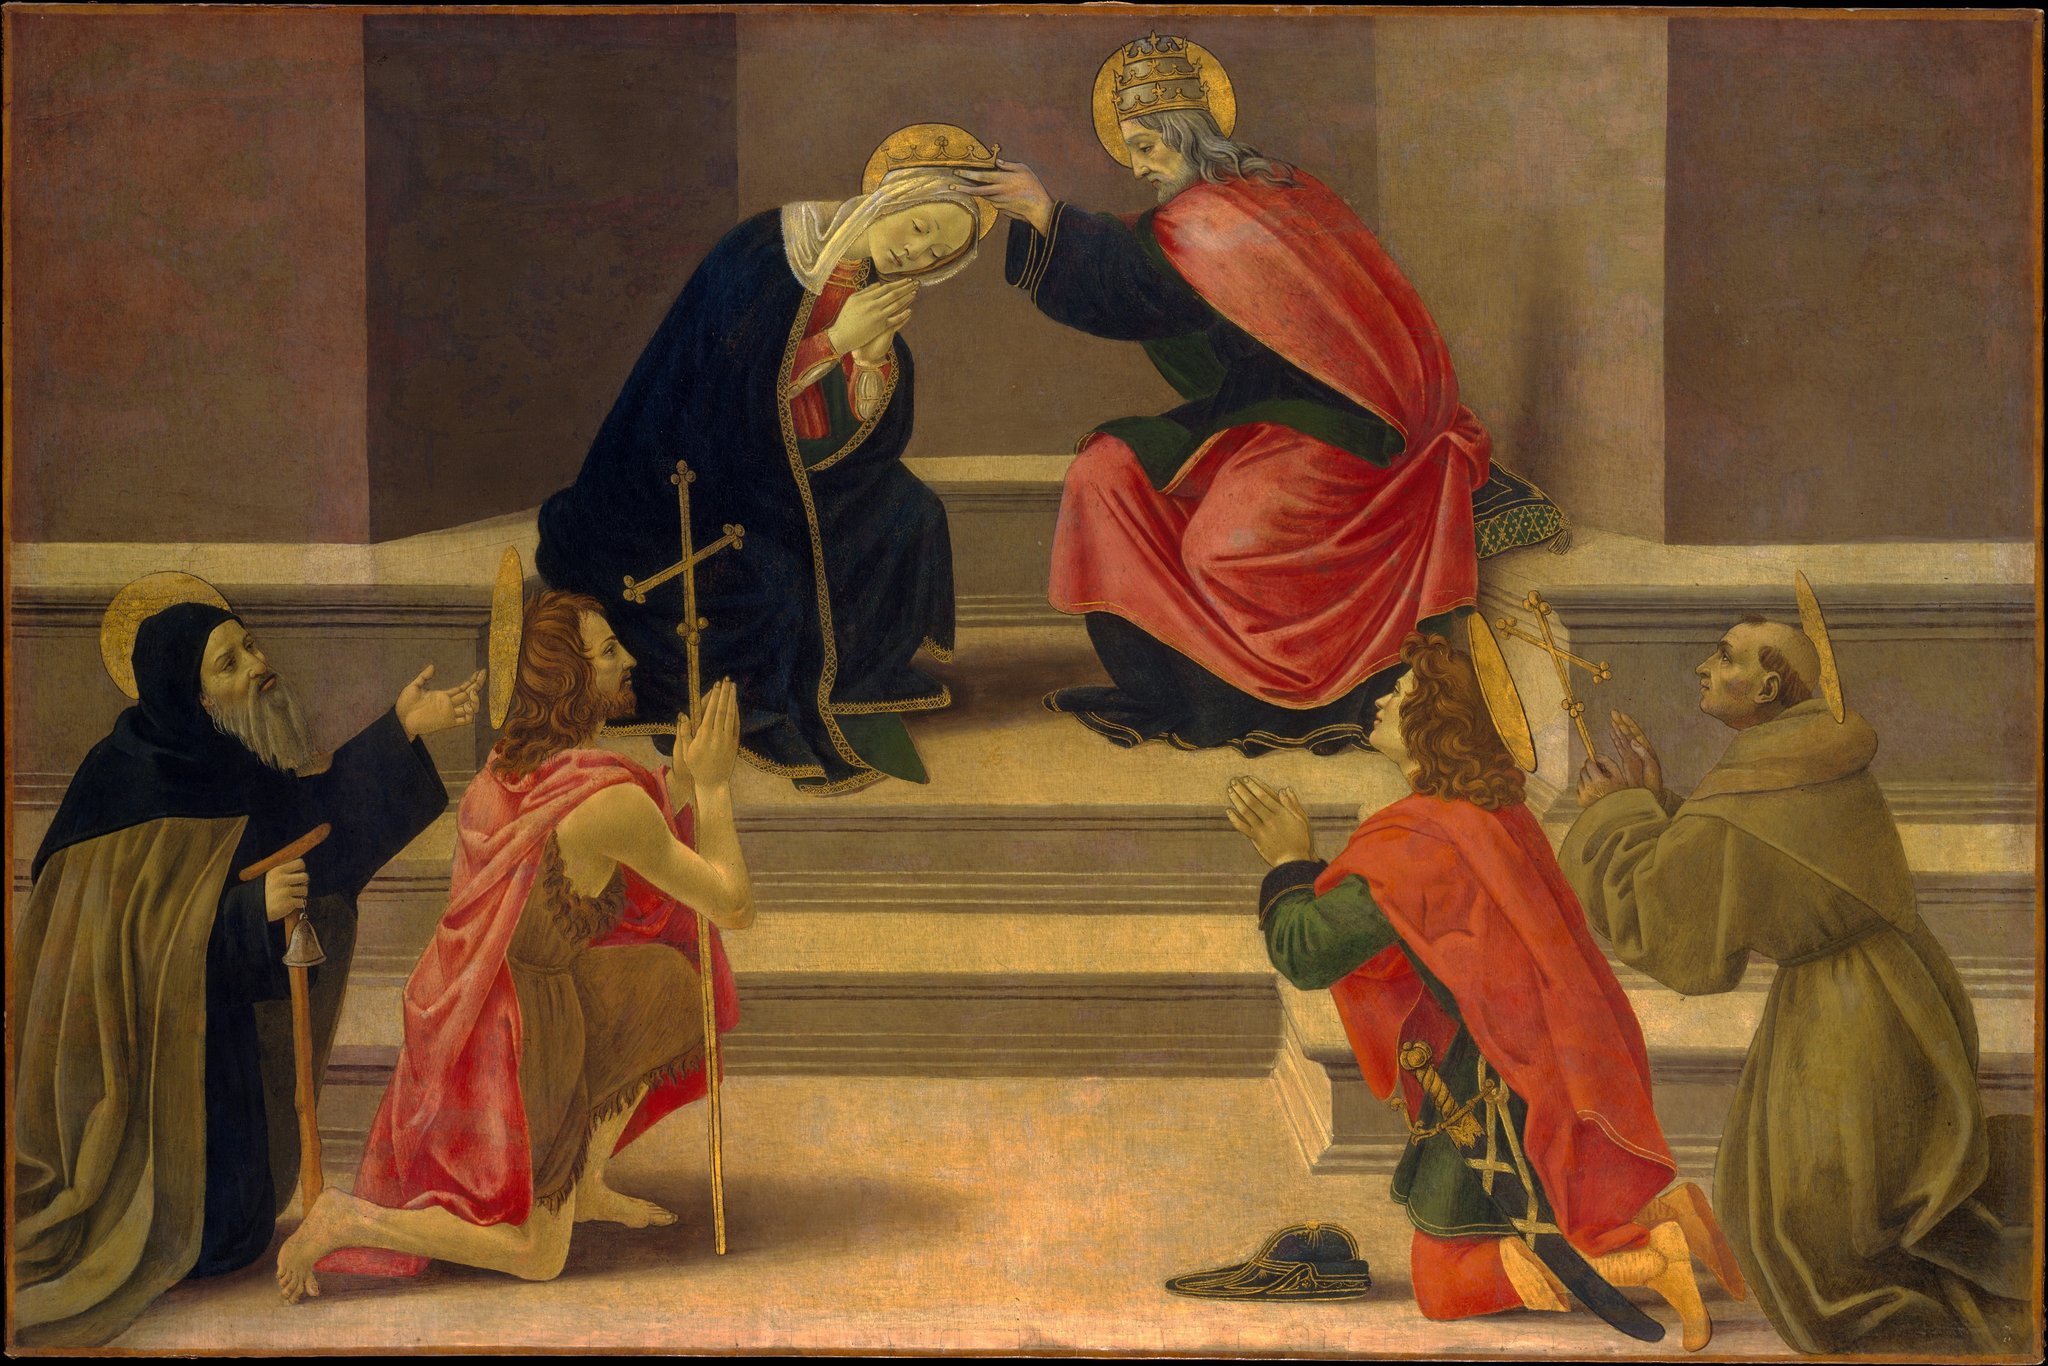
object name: painting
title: The Coronation of the Virgin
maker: botticelli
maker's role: artist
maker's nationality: italian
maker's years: 1444-1510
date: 1475-1499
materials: canvas, paint, wood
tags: men,saint francis,saint john the baptist,virgin mary,saints,coronation of the virgin